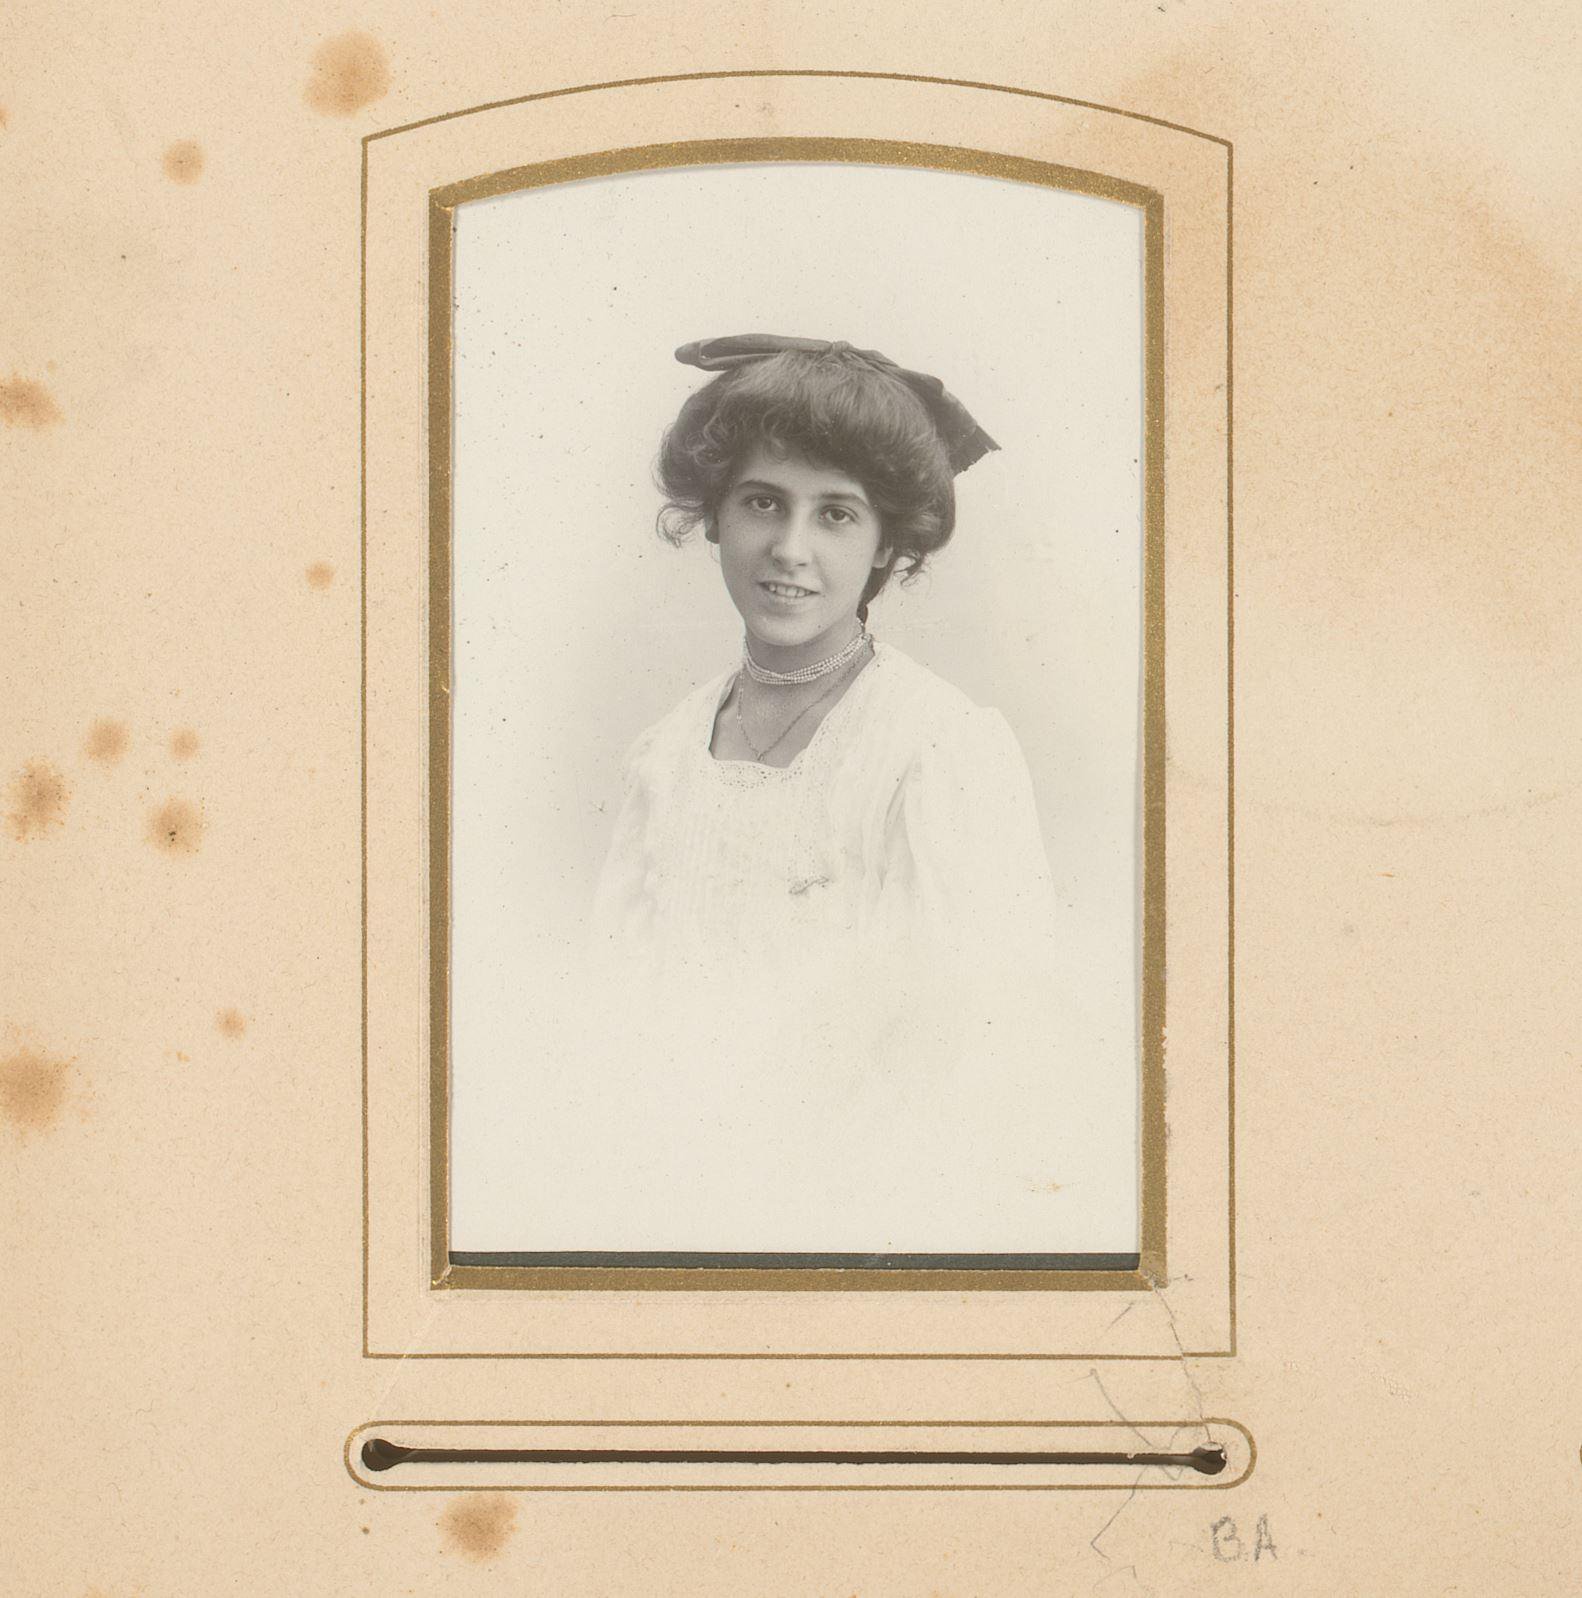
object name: album leaf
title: Portret van een jonge vrouw met strik in het haar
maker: ferdinand schmidt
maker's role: fotograaf, fotostudio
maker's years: 1840-1909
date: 1880-1920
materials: cardboard, photographic support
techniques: collodion silver print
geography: bensheim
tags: adolescent, young woman, maiden, historical persons - bb - woman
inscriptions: inscription: ‘ATELIER/ Ferdinand Schmidt/ BENSHEIM/ Auerbacherstrasse 39/ u. Schönbergerstrasse/ Platten bleiben/ aufbewahrt’